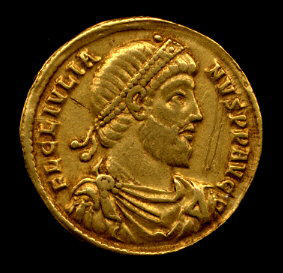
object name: solidus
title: Gold Solidus of Julian (361–63)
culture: byzantine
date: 361-363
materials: gold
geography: constantinople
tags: men,profiles